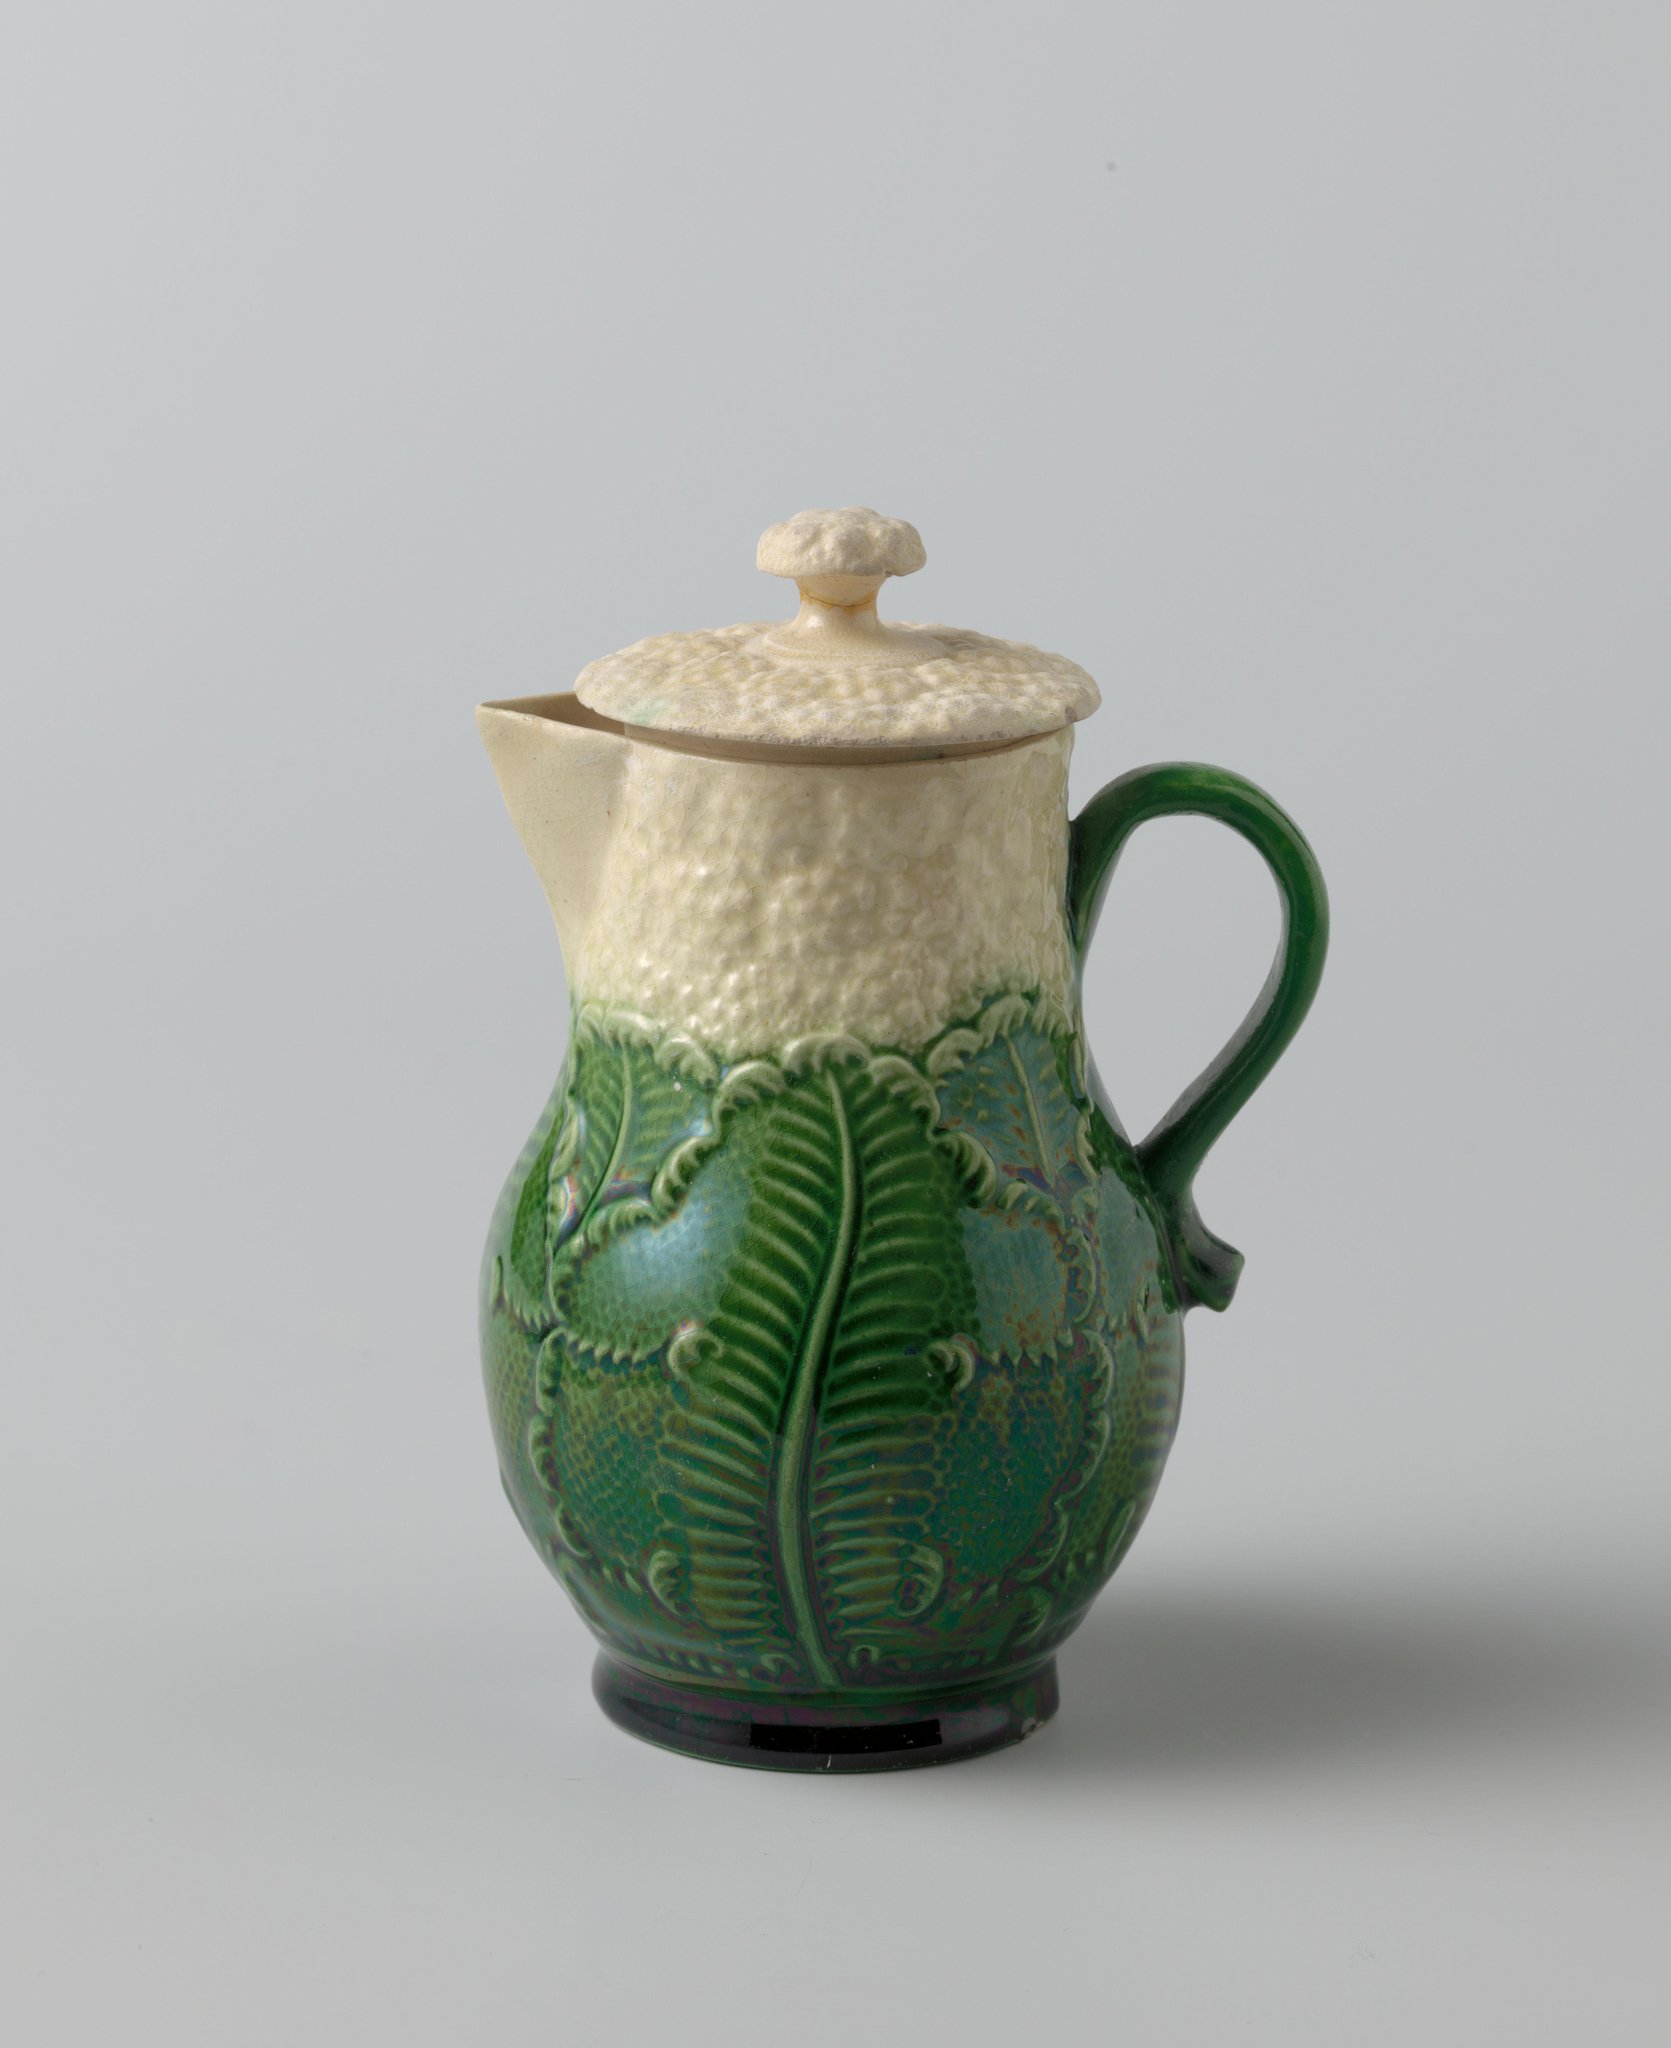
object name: milk jug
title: Melkkan van hardgebakken aardewerk; Whieldon ware, cauliflower ware.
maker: Anonymous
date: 1765-1775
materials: earthenware, glaze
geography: england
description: Peervormige melkkan van hardgebakken aardewerk. De kan heeft een driehoekige sneb, een C-vormig oor. De melkkan heeft het uiterlijk van een bloemkool door de decoratie in reliëf en de kleuren groen en wit. Bij de melkkan hoort een theepot met invnr. BK-NM-13200-B.